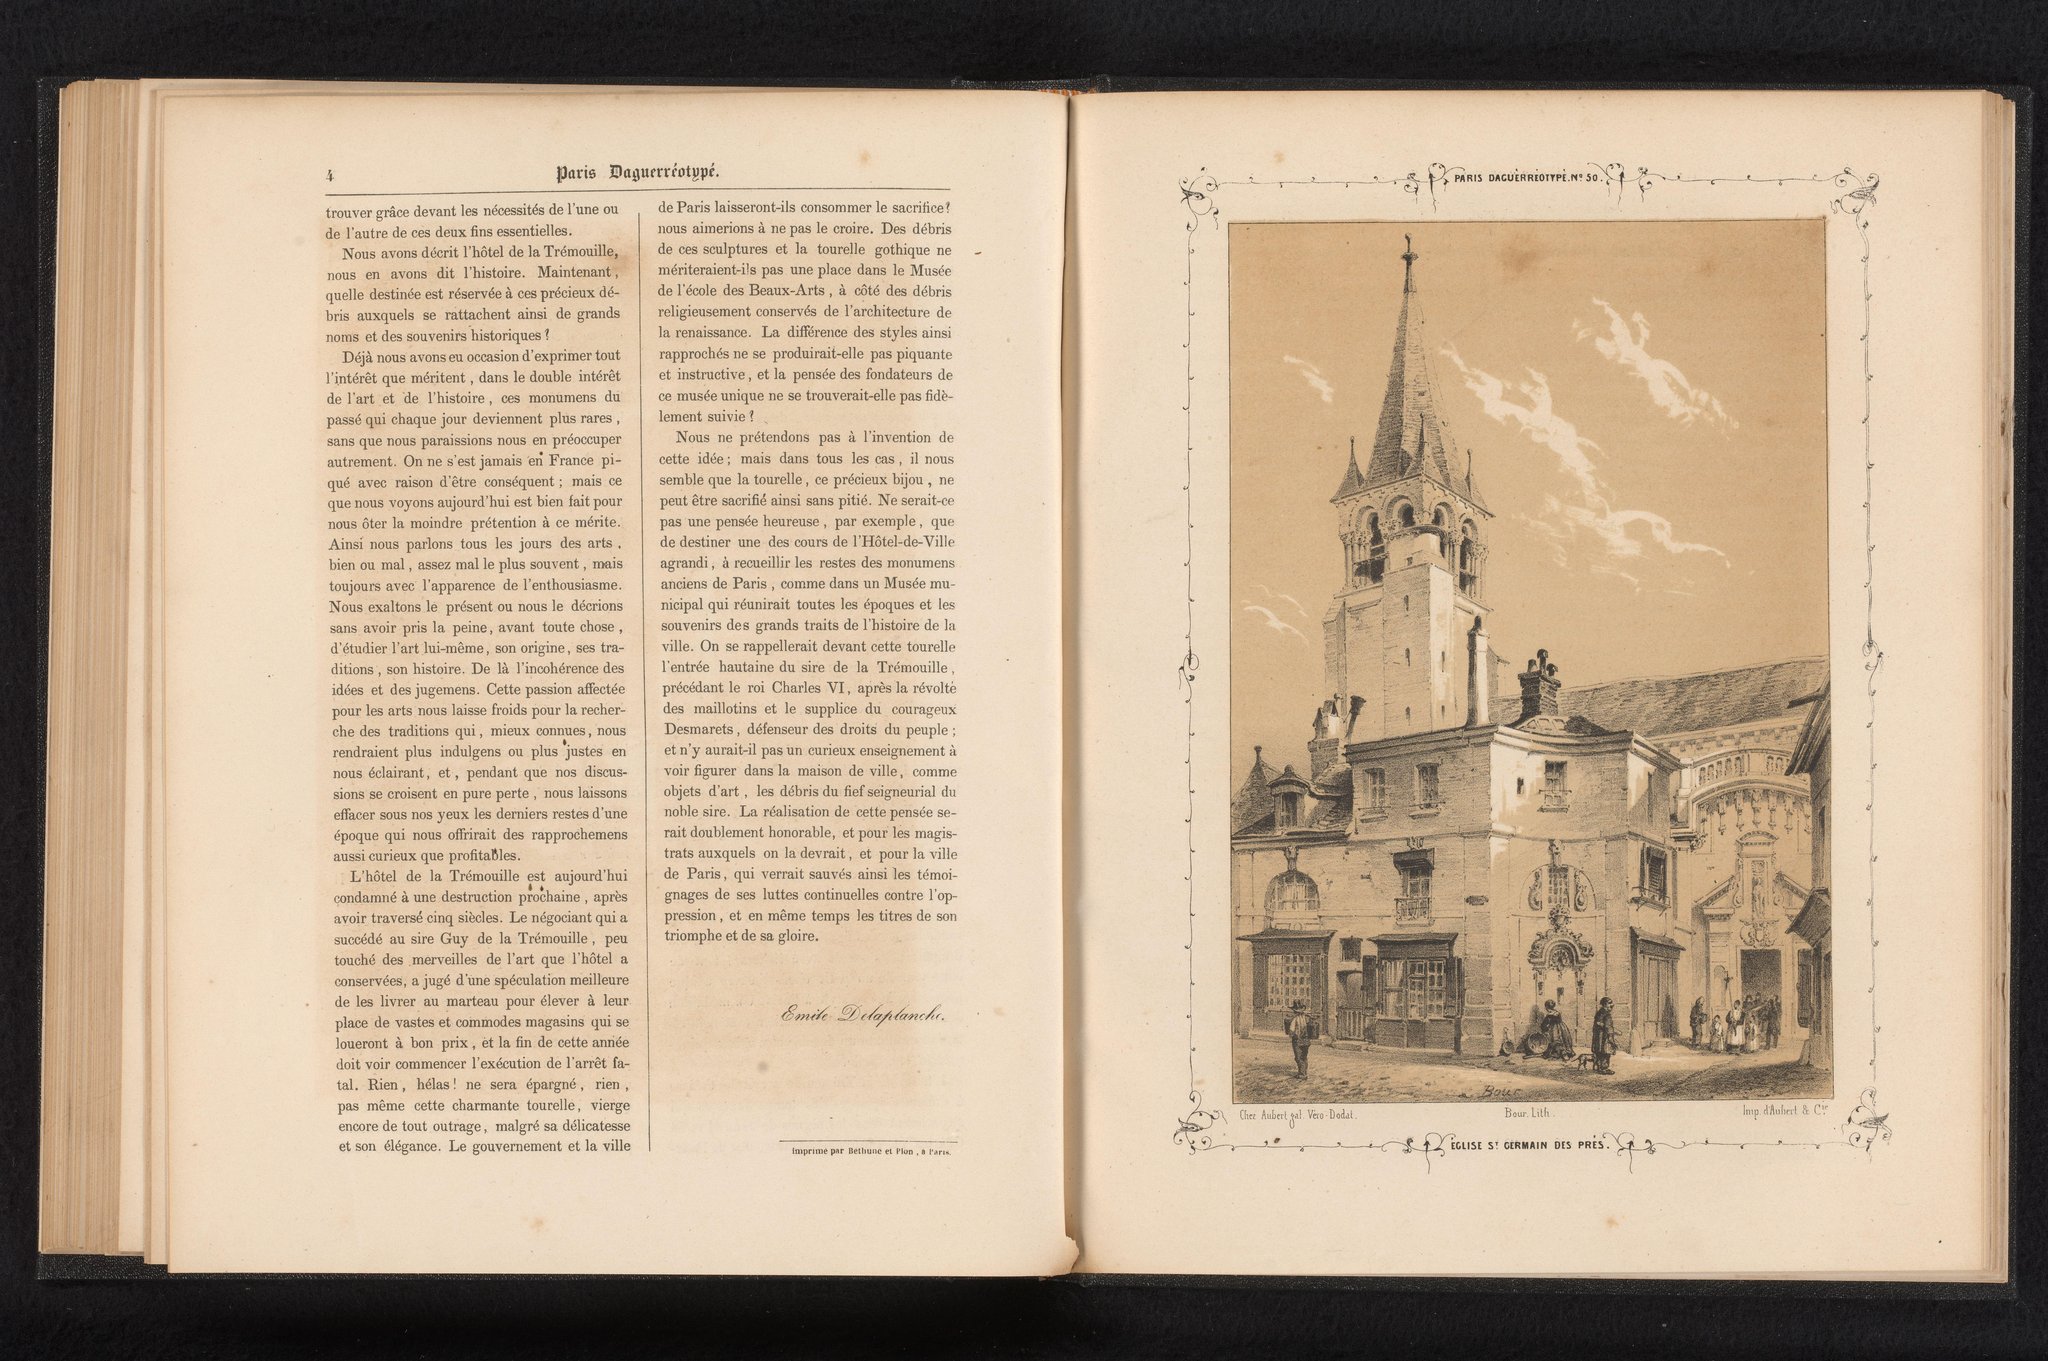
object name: print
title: Église Saint-Germain-des-Prés in Parijs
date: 1839-1840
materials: paper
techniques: tone lithography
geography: paris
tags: church (exterior)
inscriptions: inscription: ‘PARIS DAGUERRÉOTYPÉ No. 50.’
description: Prent op honderdnegenennegentigste ongenummerde pagina.